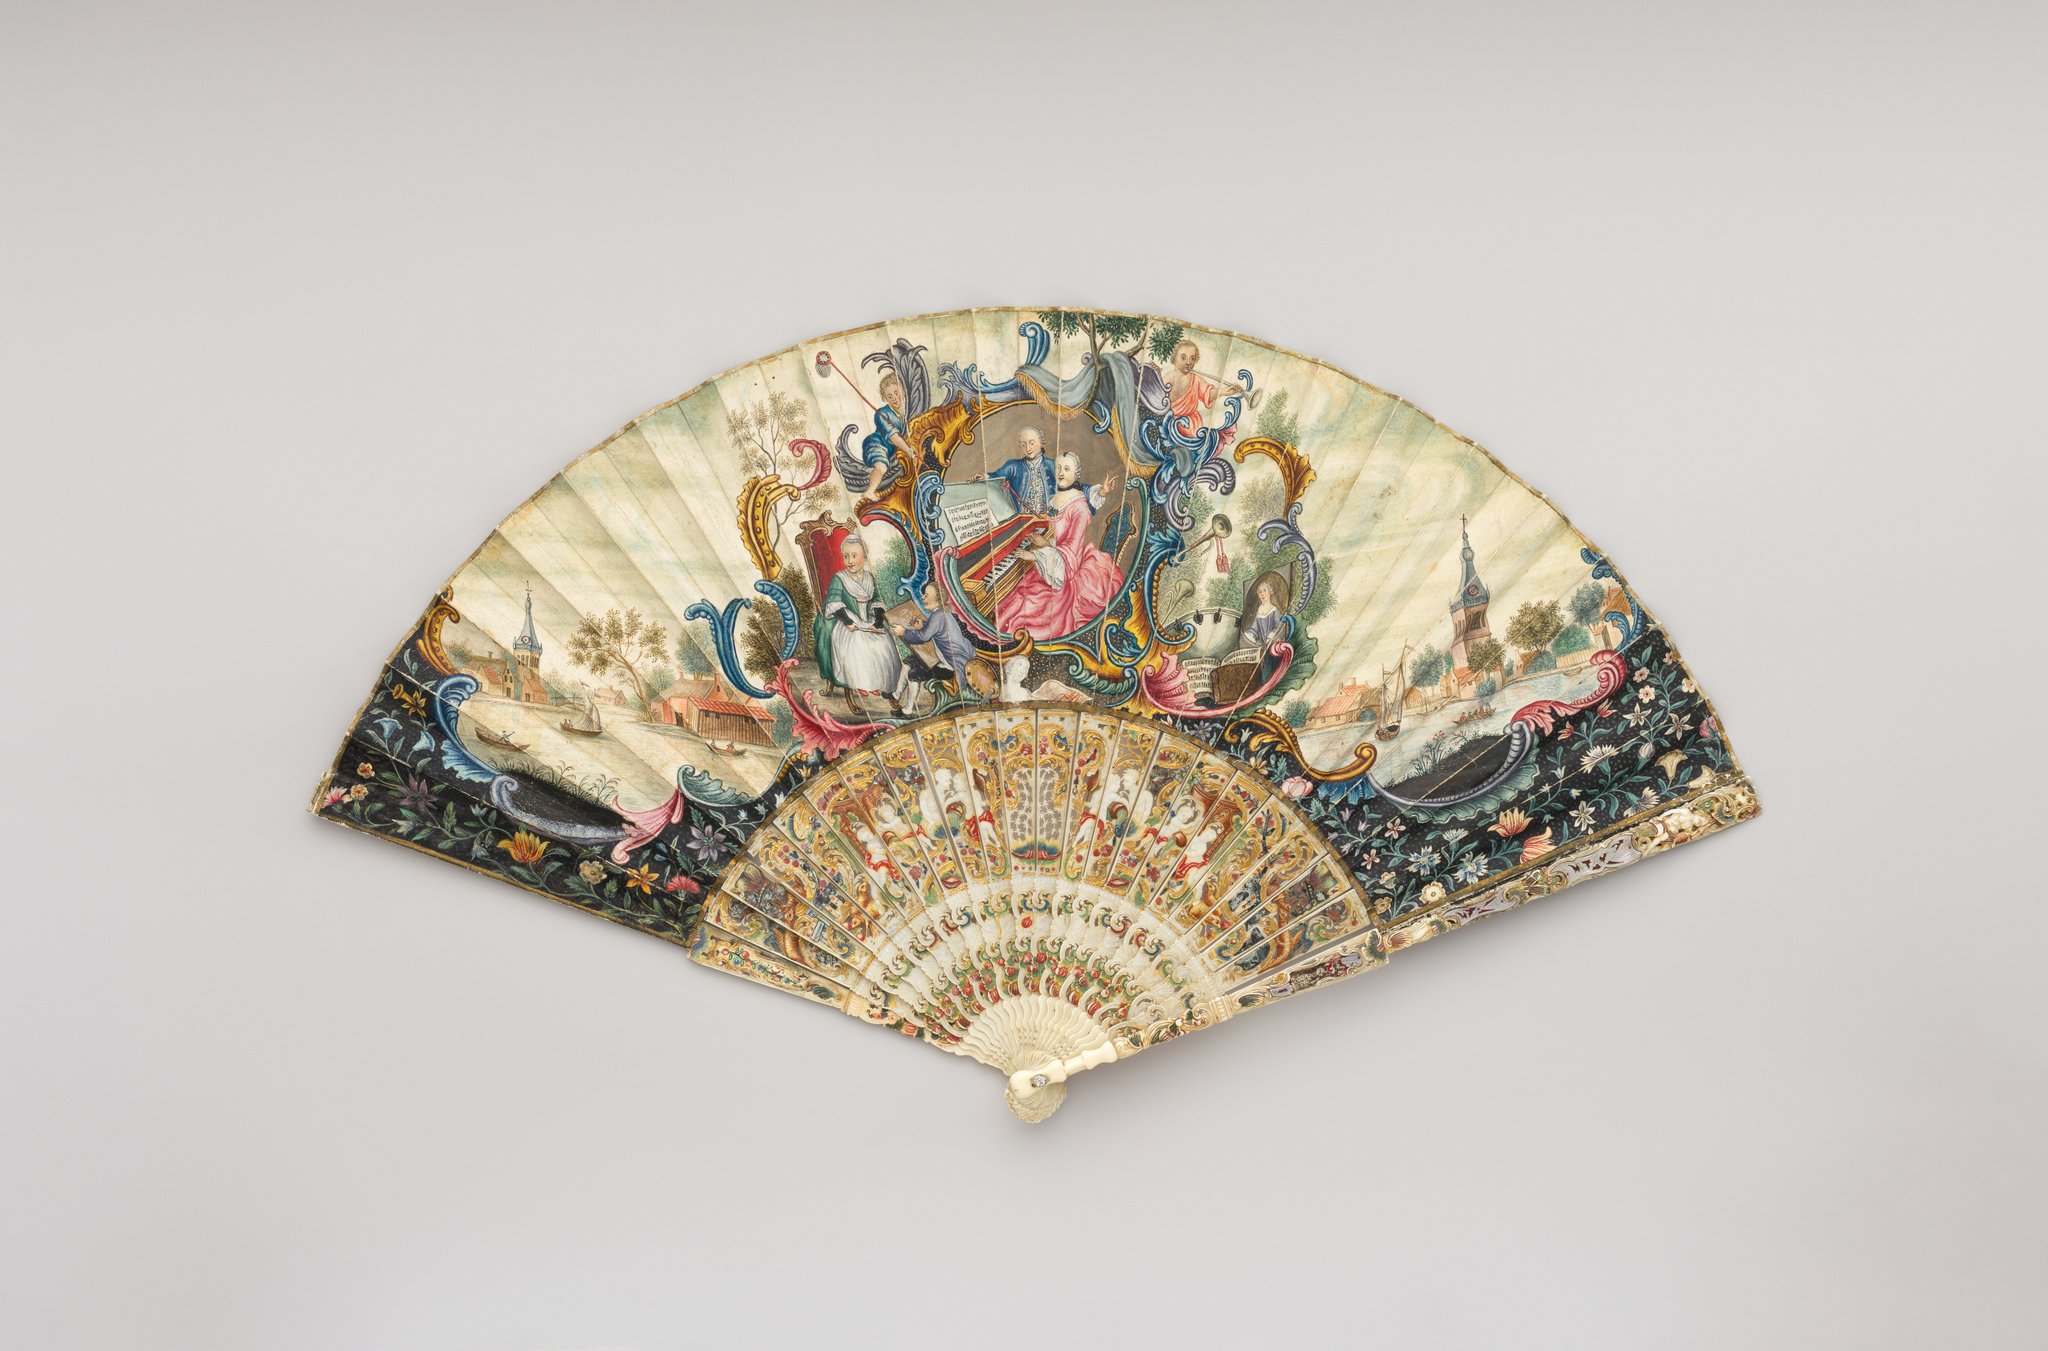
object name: fan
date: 1701-1800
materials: gilt, glass, ivory, mother of pearl, paint, paper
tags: musical instruments,men,women,music